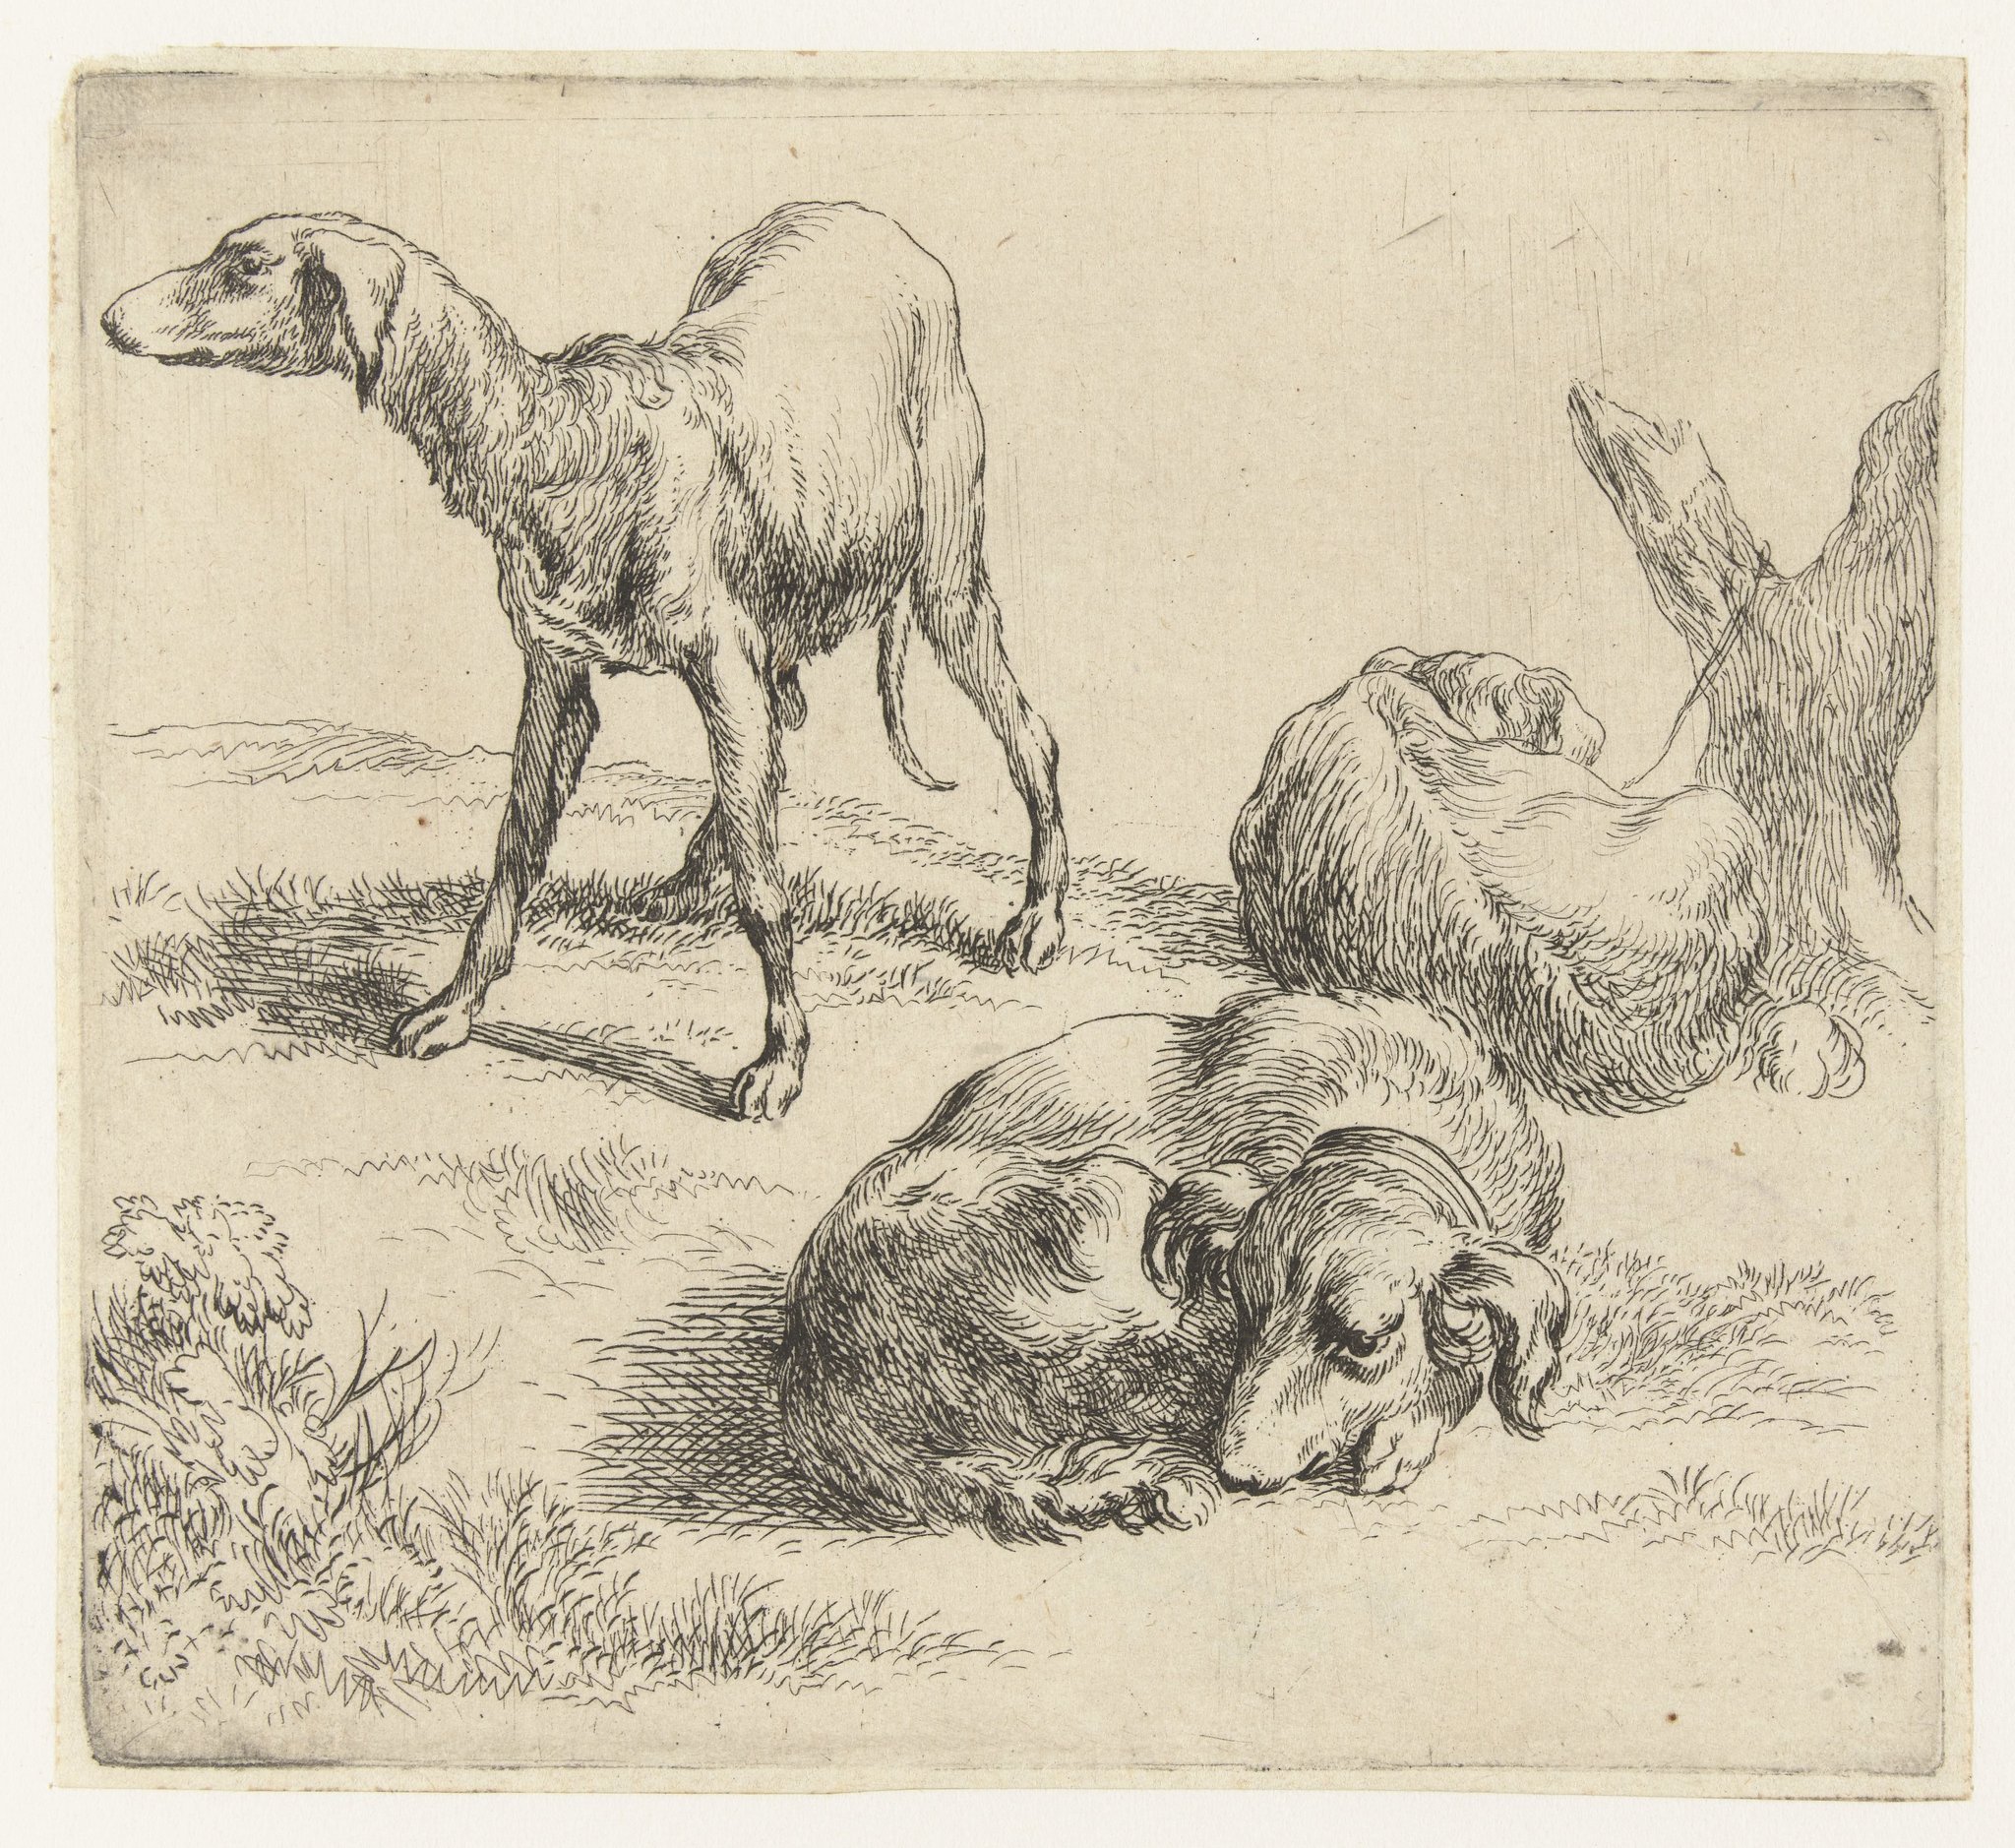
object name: print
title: Animalia ad vivum delineata et aqua forti aeri impressa Studio et Arte Nicolai Berchemi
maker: nicolaes pietersz berchem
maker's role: draughtsman, print maker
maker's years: 1620-1683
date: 1648-1652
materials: paper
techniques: etching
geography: netherlands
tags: dog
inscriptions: collector's mark: Lugt 240